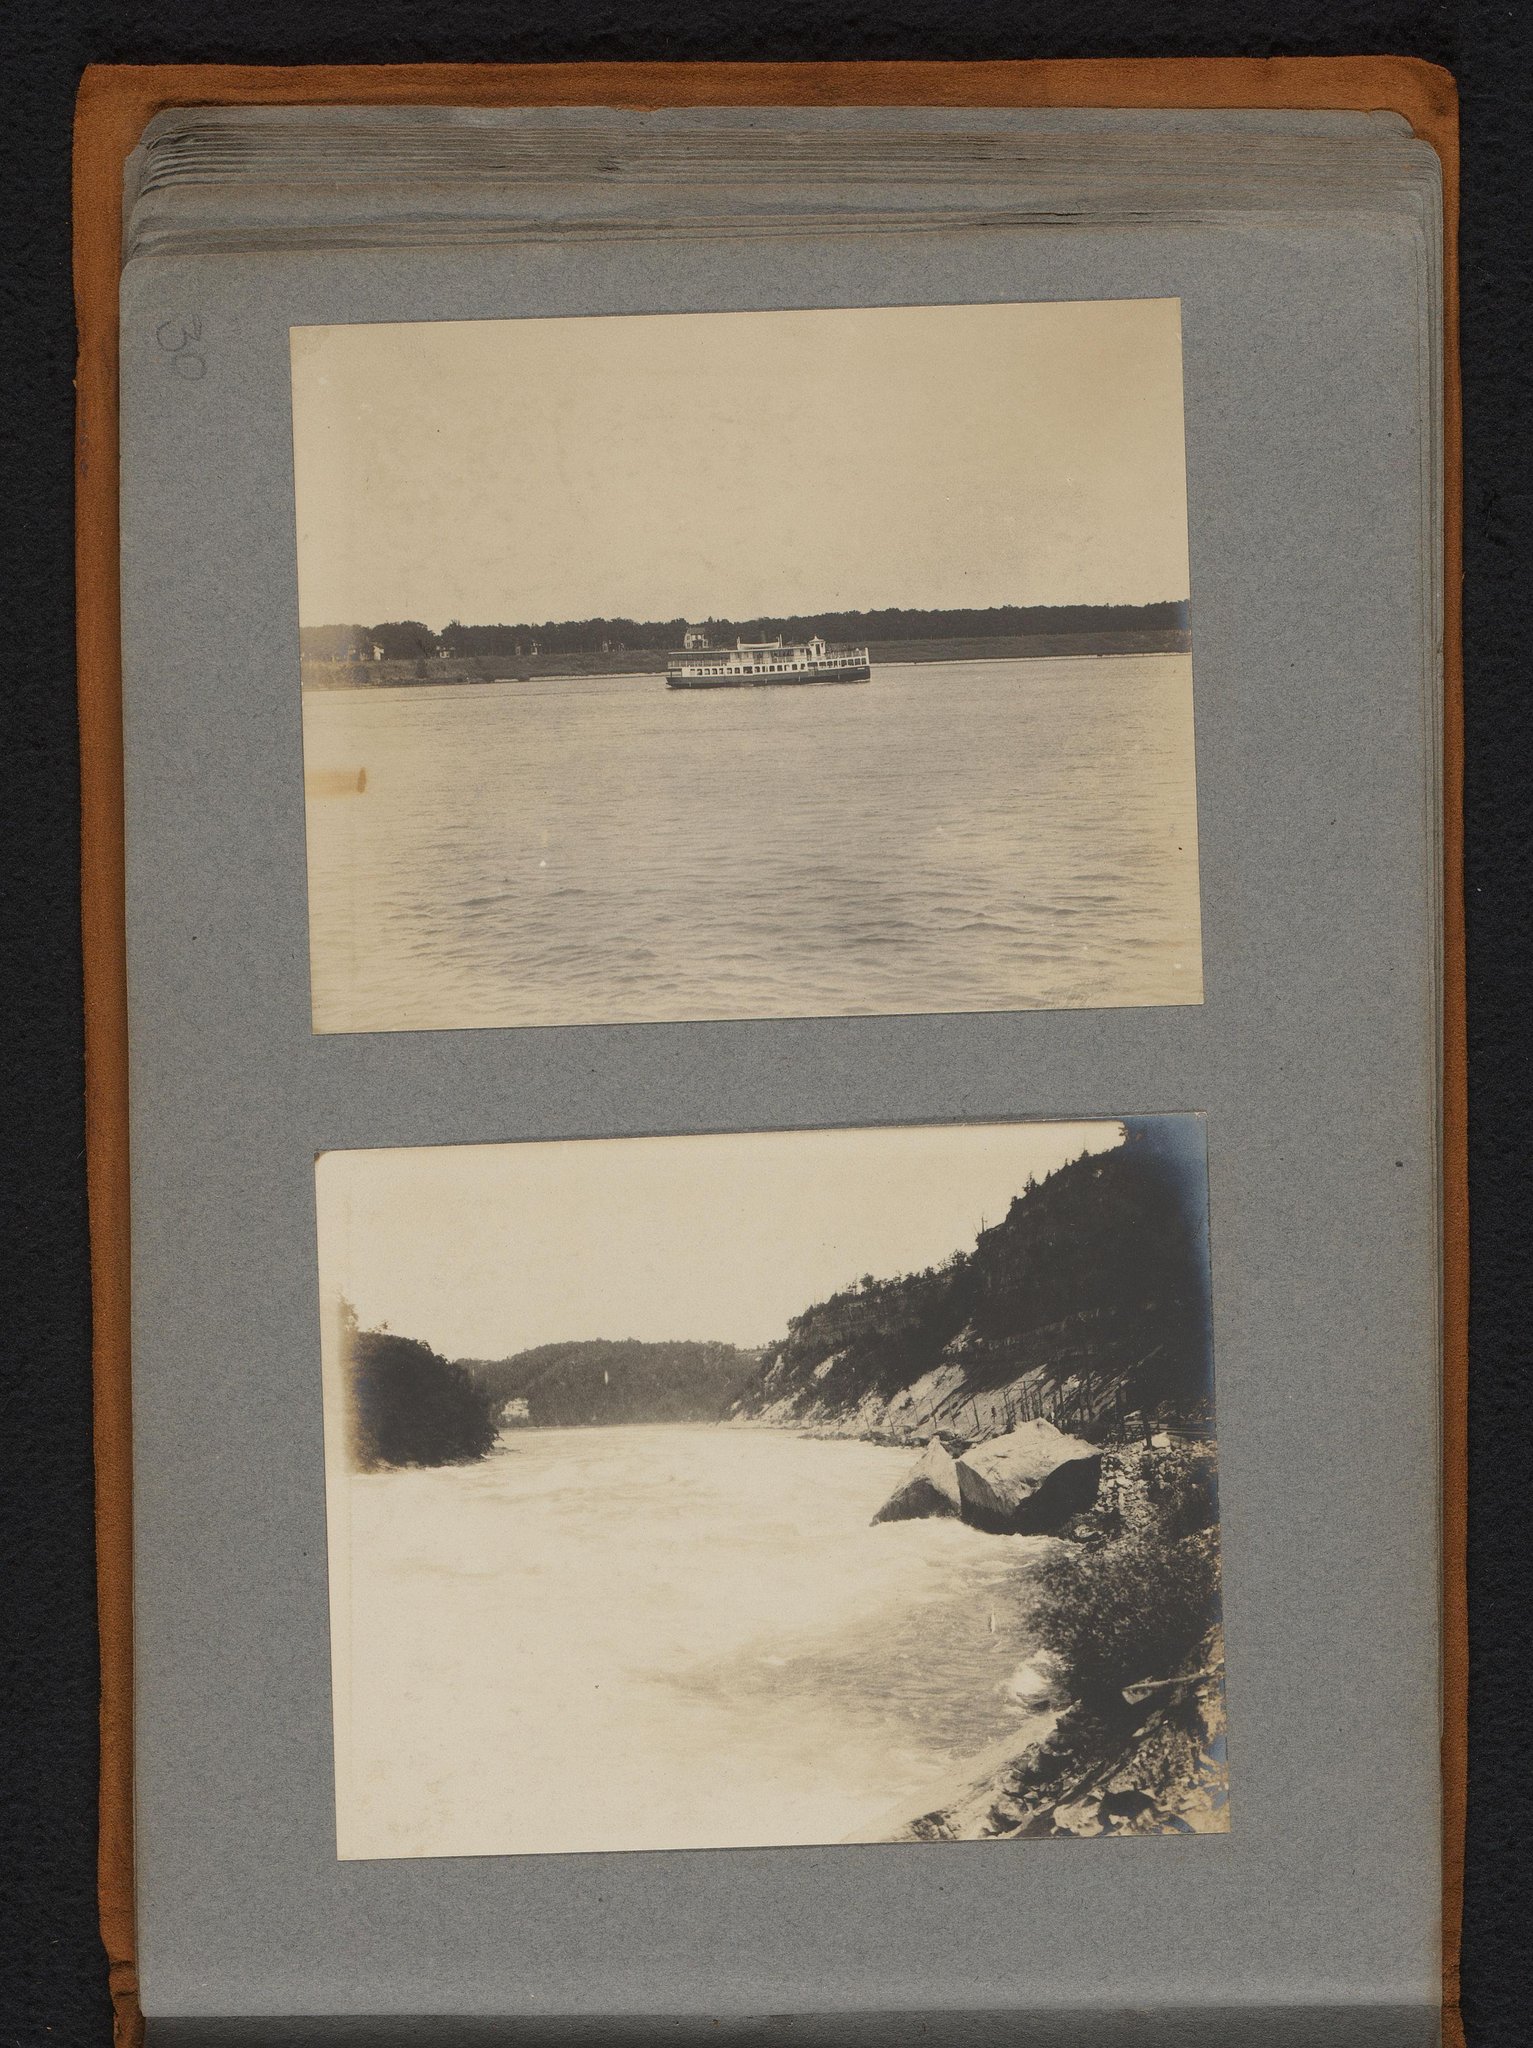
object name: photograph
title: Stoomschip te water en gezicht op een meer of rivier, mogelijk nabij de Niagarawatervallen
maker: jan van der mey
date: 1902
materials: paper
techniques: gelatin silver print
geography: north america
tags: river bank, lake, steamship, motorship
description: Deze foto's maken deel uit van een album.